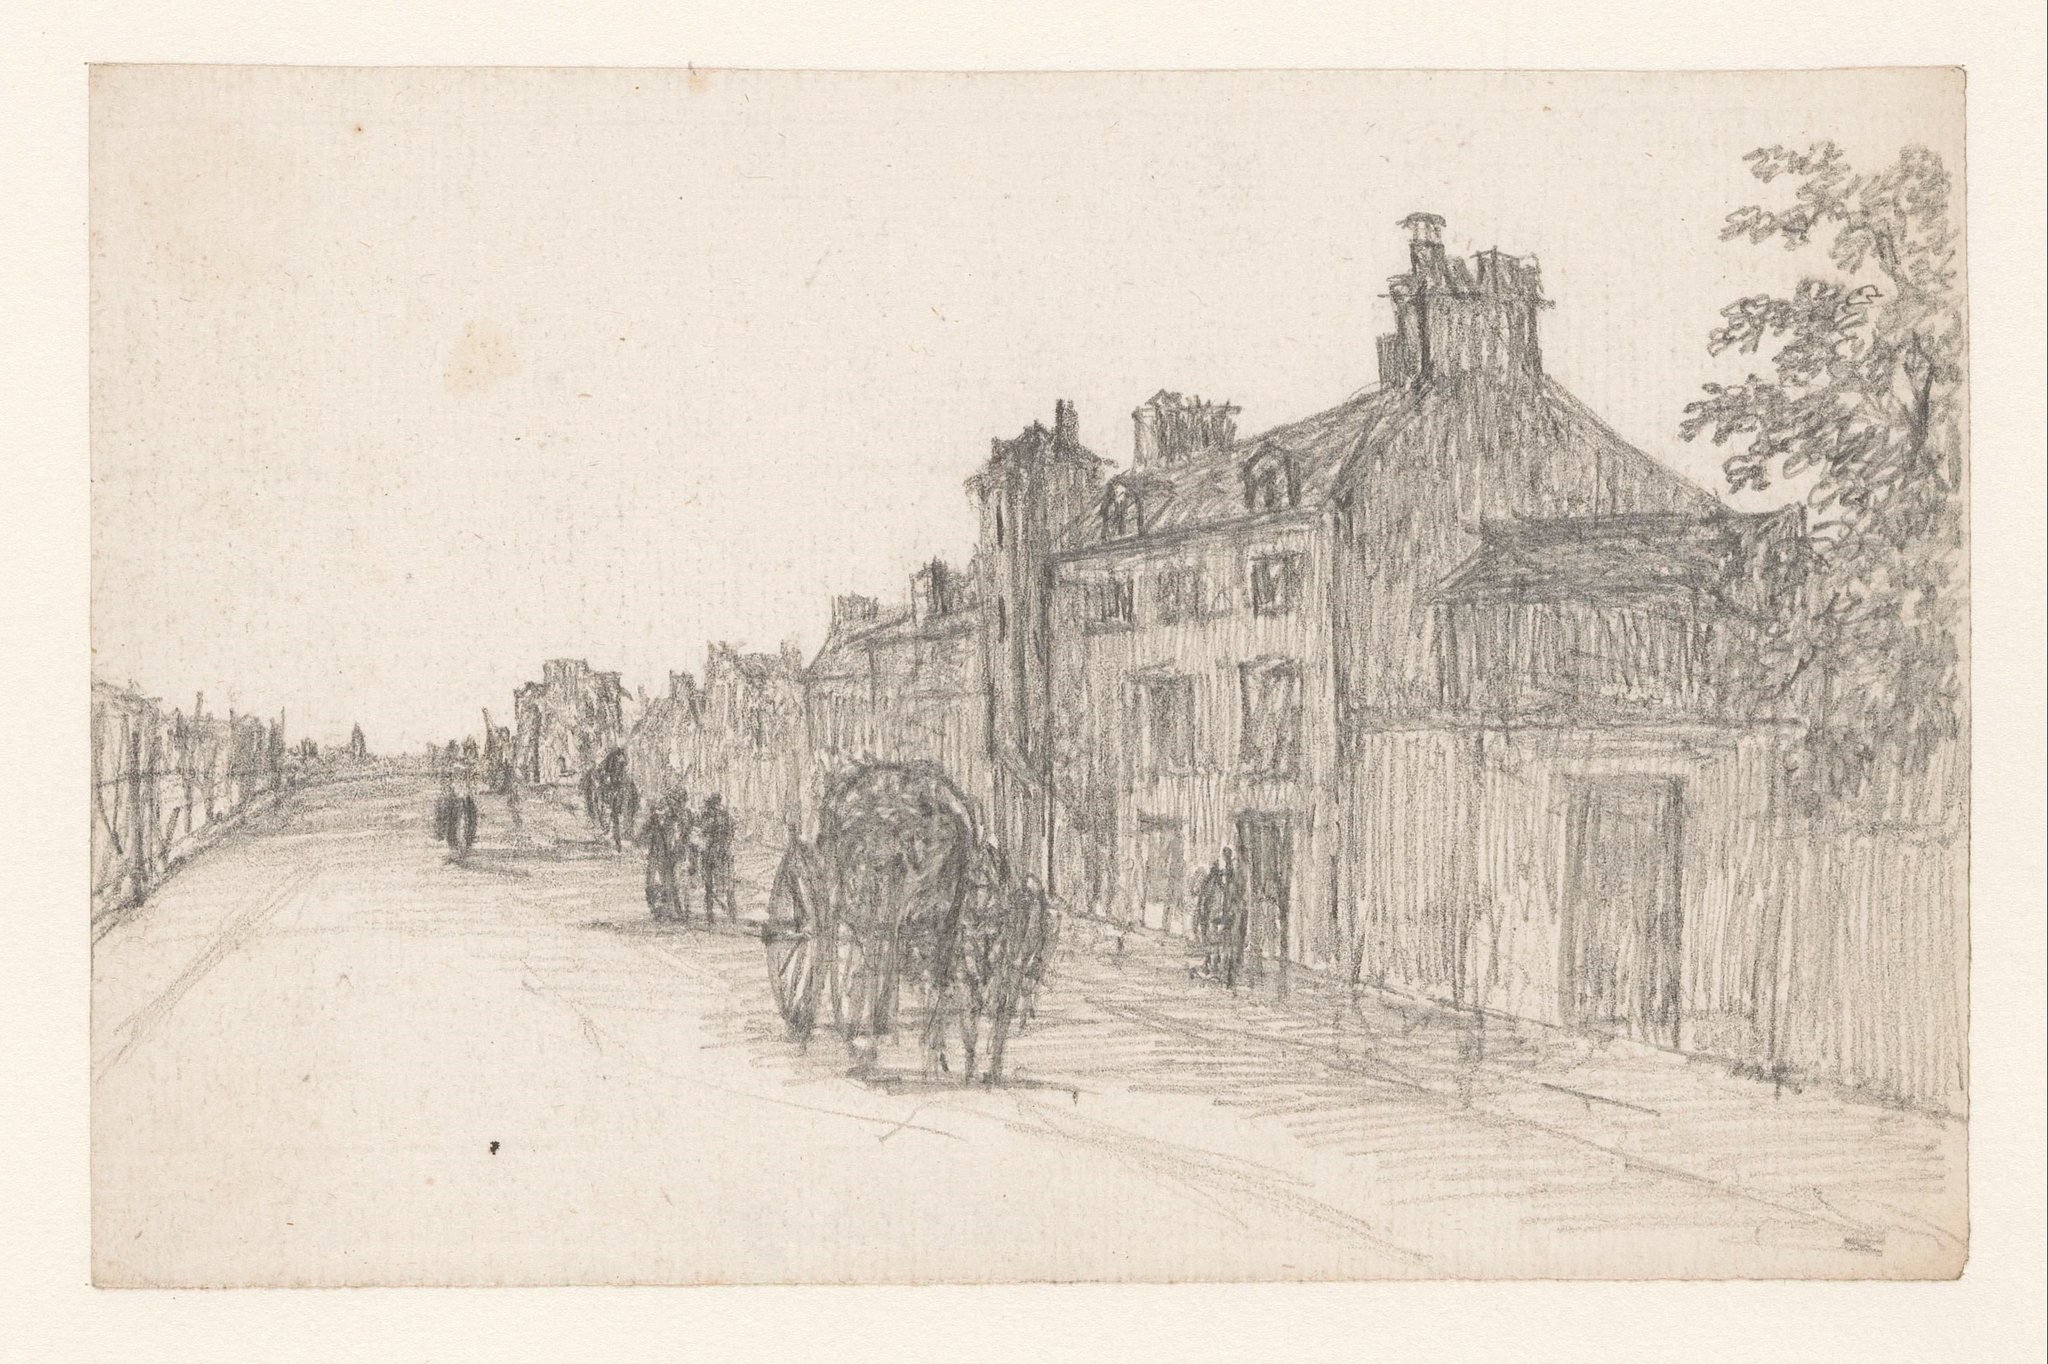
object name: drawing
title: Straatweg met sleperskar; rechts huizen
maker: georges michel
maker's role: draughtsman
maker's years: 1763-1843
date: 1773-1843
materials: paper, pencil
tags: (farm) wagon, freight wagon, cart, street (+ city(-scape) with figures, staffage)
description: Een van 120 tekeningen, afkomstig uit een 19e eeuws album met tekeningen van Georges Michel.